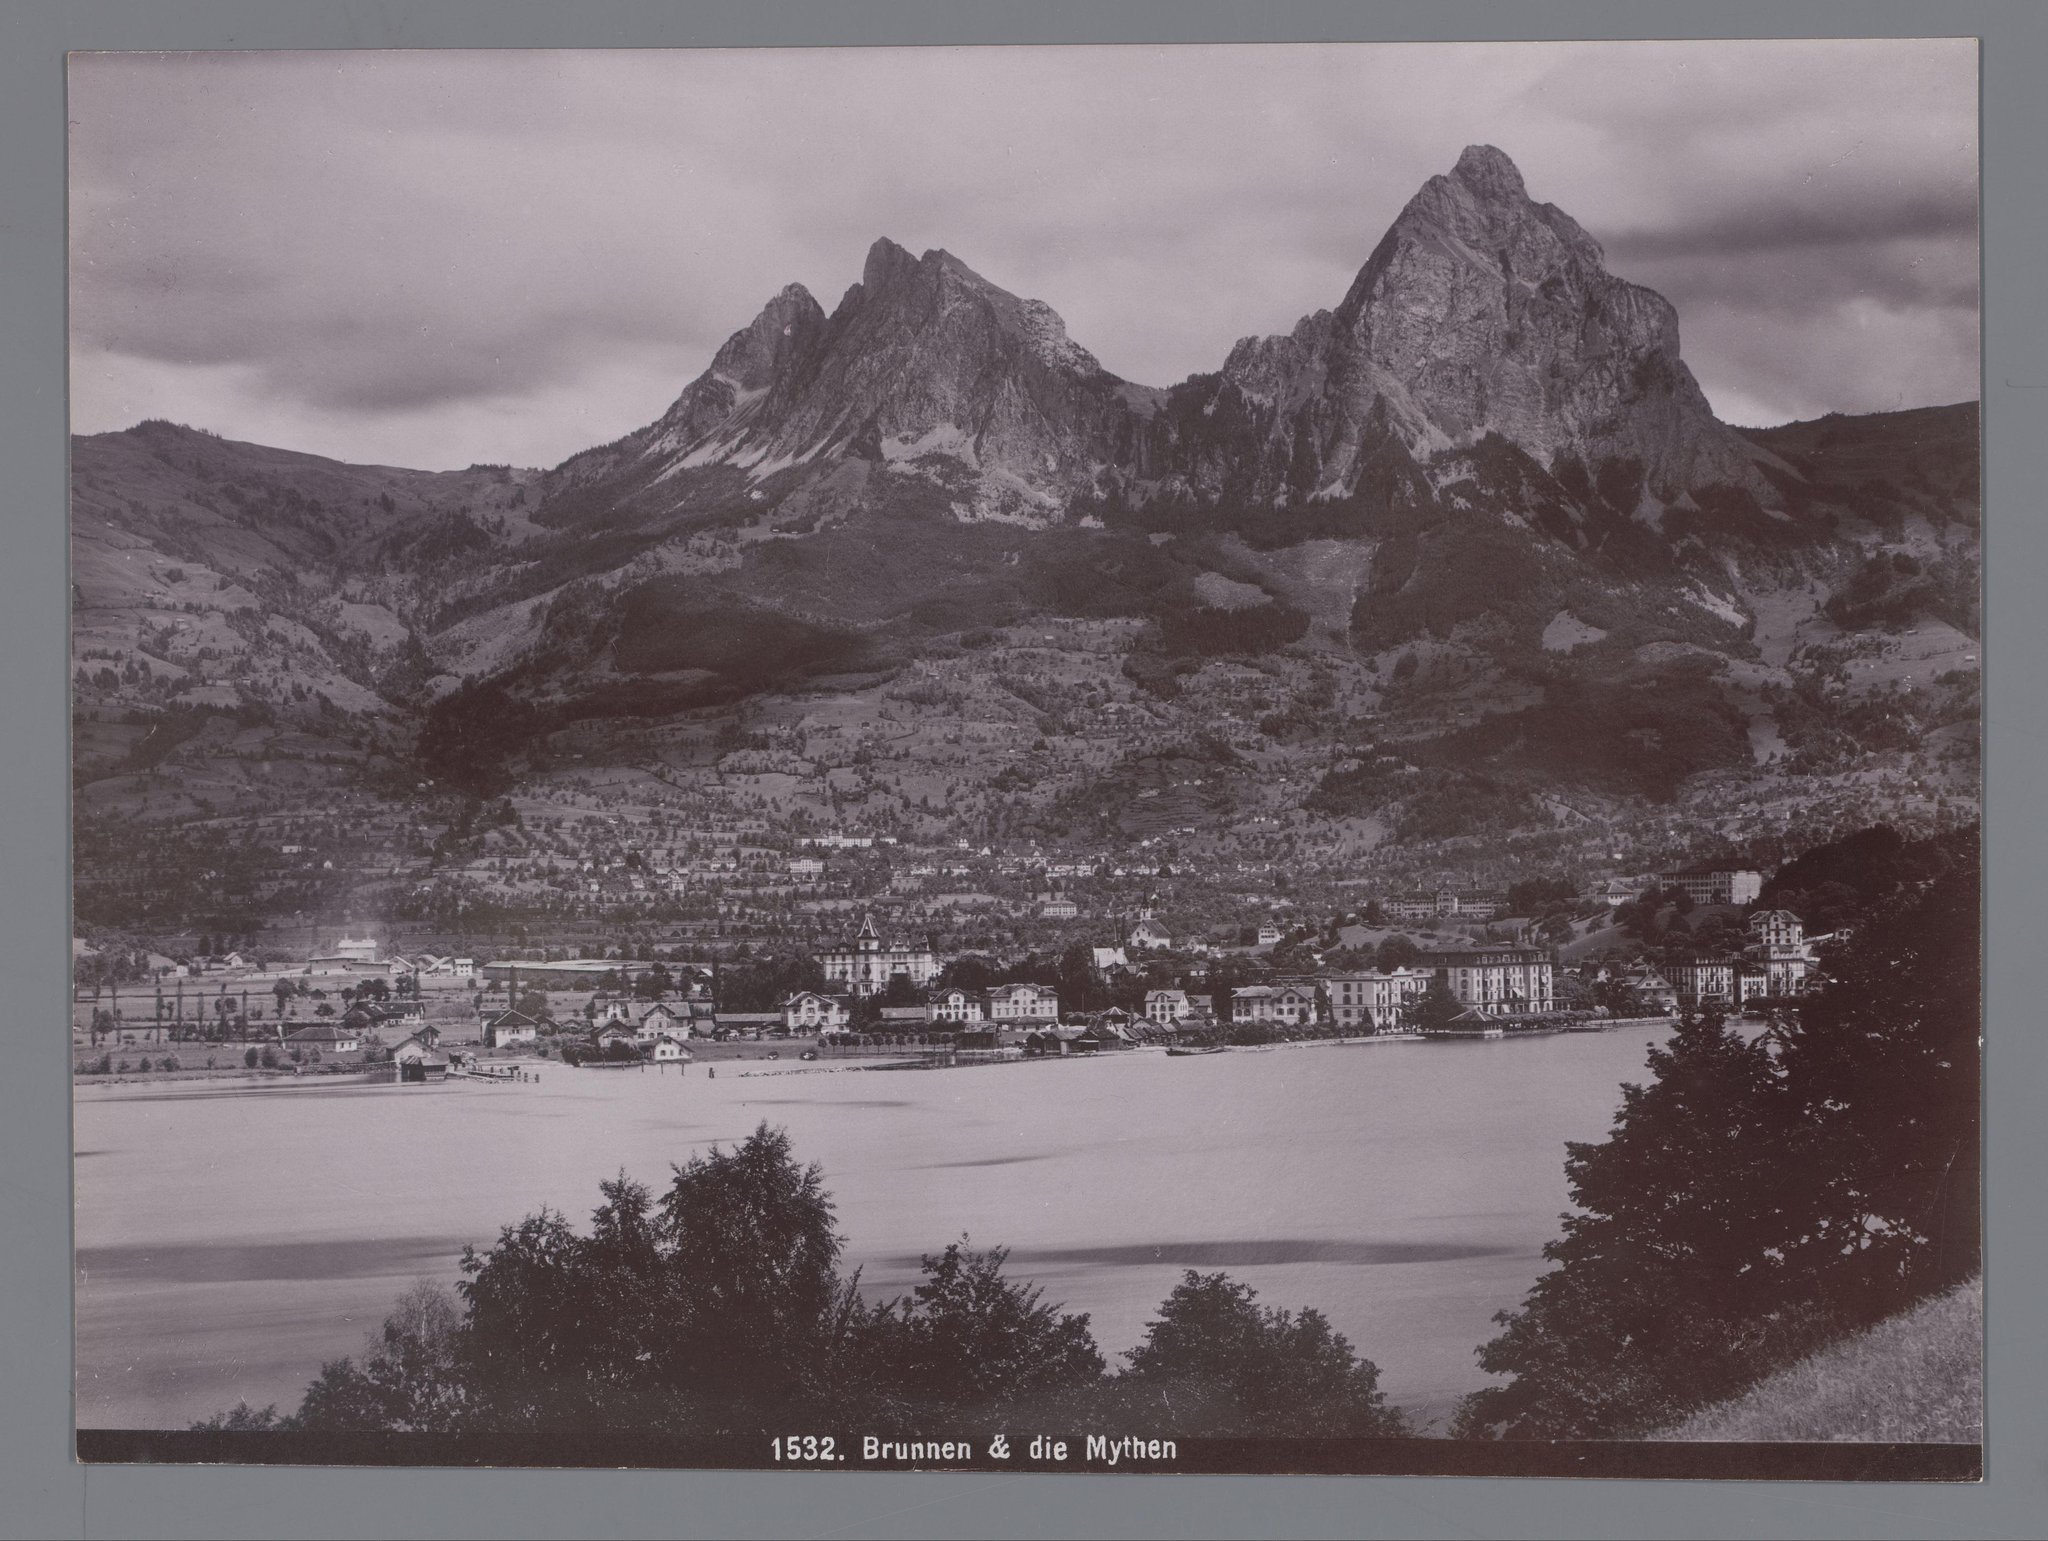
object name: photograph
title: De plaats Brunnen en de twee 'Mythen' (gebergte), Zwitserland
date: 1900-1920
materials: paper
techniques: gelatin silver print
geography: switzerland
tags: brunnen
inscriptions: inscription: ‘1532. Brunnen & die Mythen’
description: Brunnen ligt aan de Vierwaldstättersee in Midden-Zwitserland. Op de achtergrond zijn twee markante bergtoppen - 'de twee Mythen' - te zien.